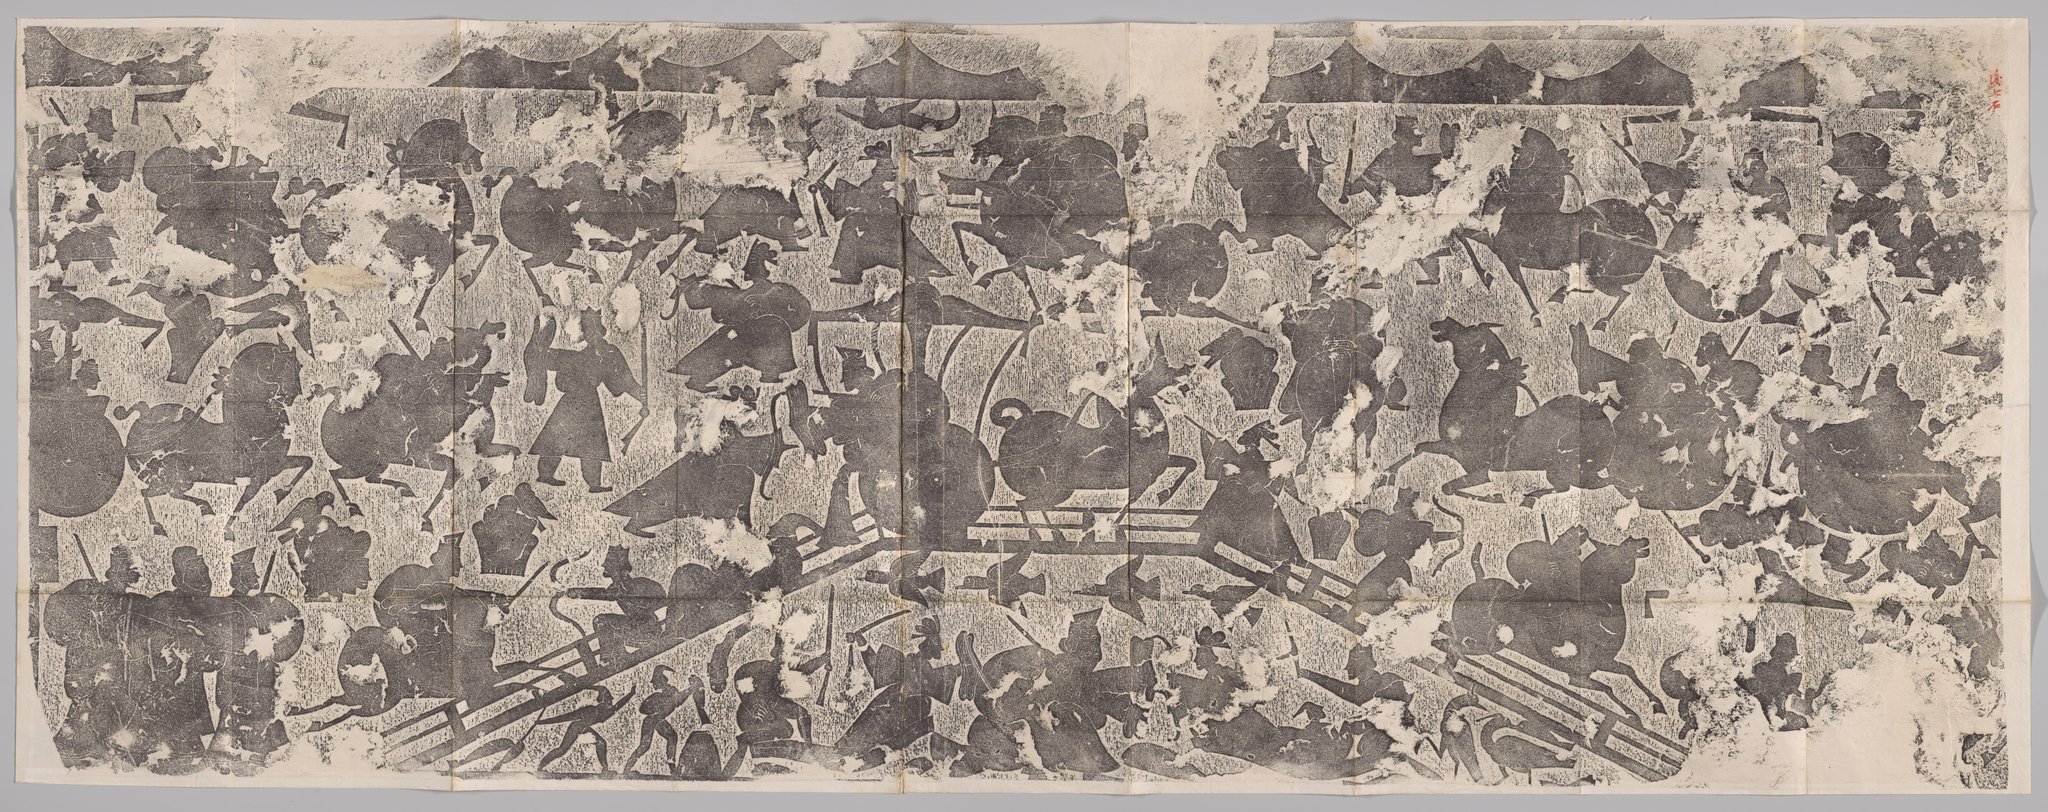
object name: wrijfprent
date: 1900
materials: ink, paper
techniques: rubbing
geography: china